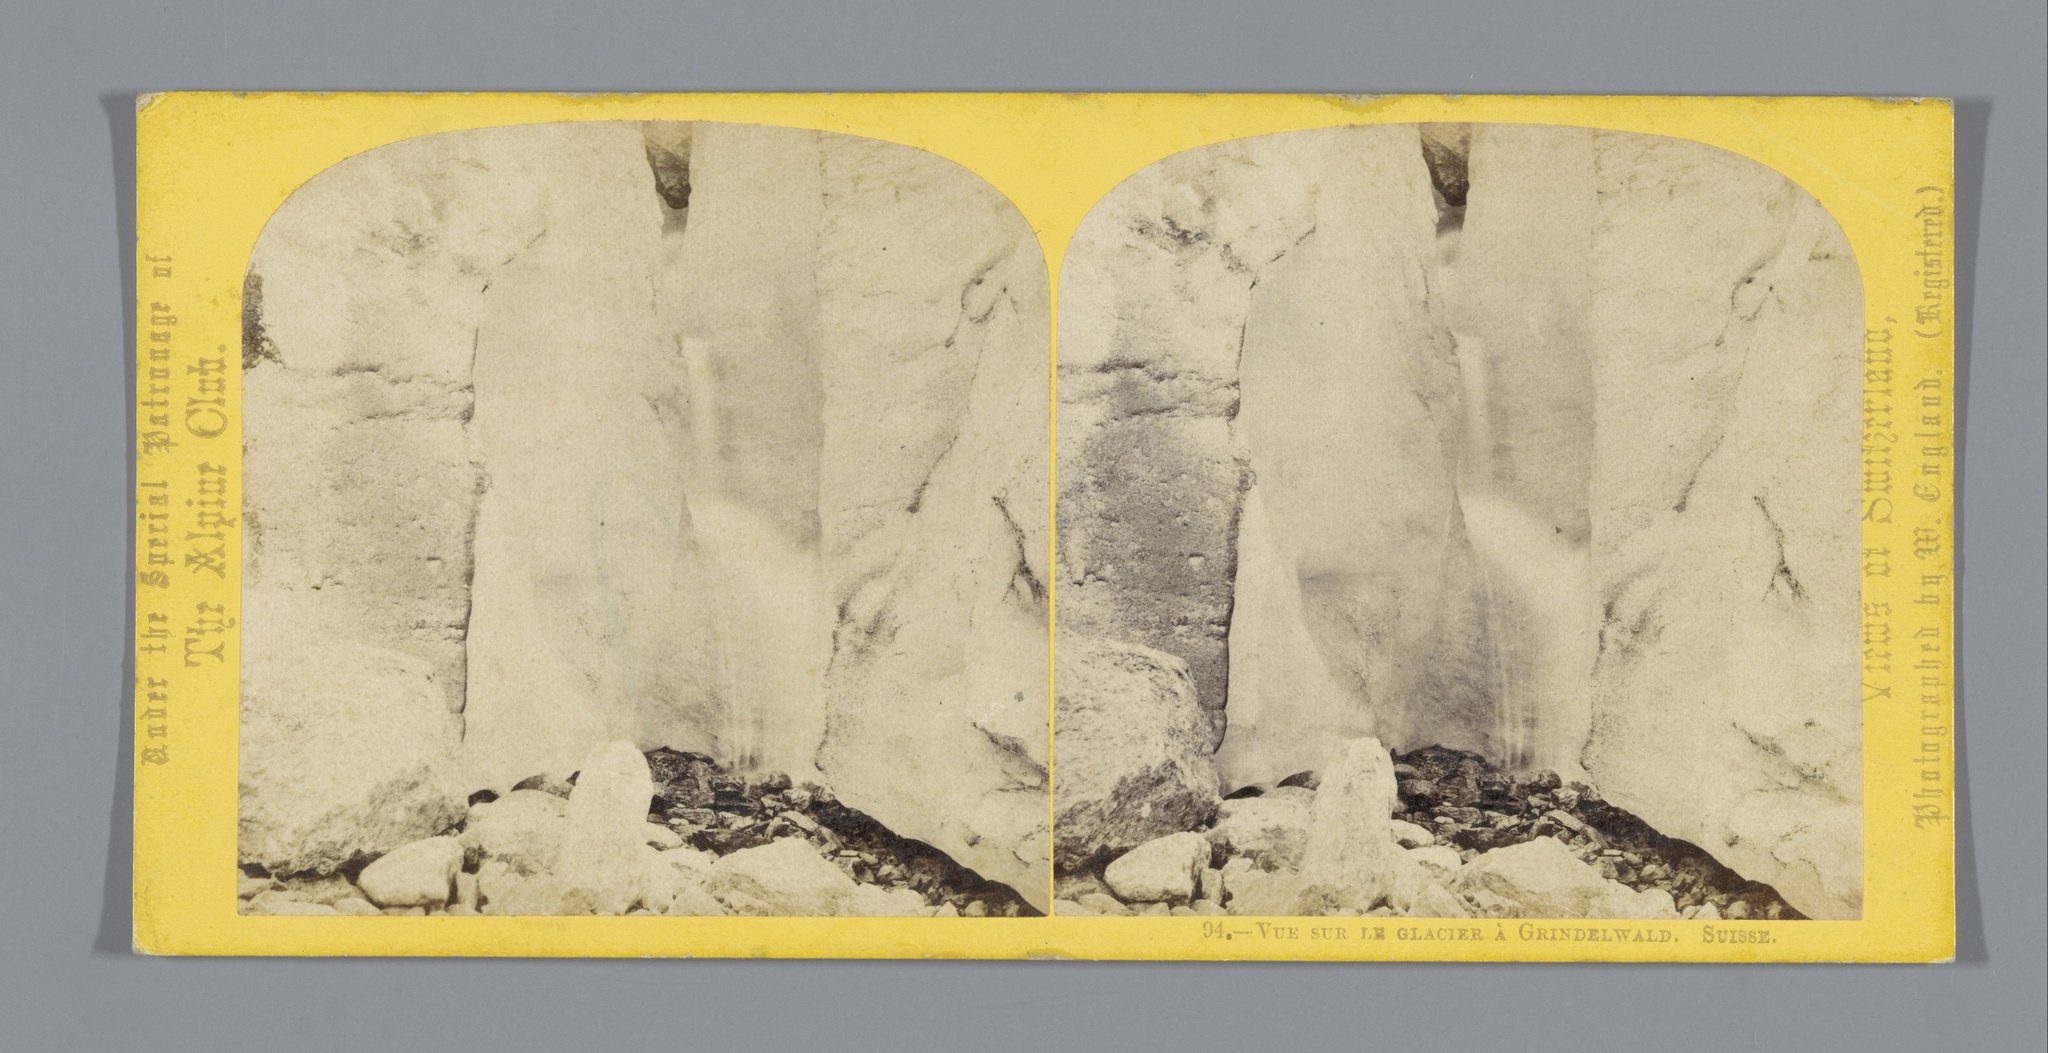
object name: stereograph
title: Vue sur le glacier à Grindelwald. Suisse.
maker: william england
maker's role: fotograaf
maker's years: 1816-1896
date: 1850-1880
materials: cardboard, photographic support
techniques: albumen print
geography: bern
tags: glacier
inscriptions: inscription: ‘Views of Switzerland, photographed by W. England. (Registered) Under the Special Patronage of the Alpine Club.’, number: ‘94.’